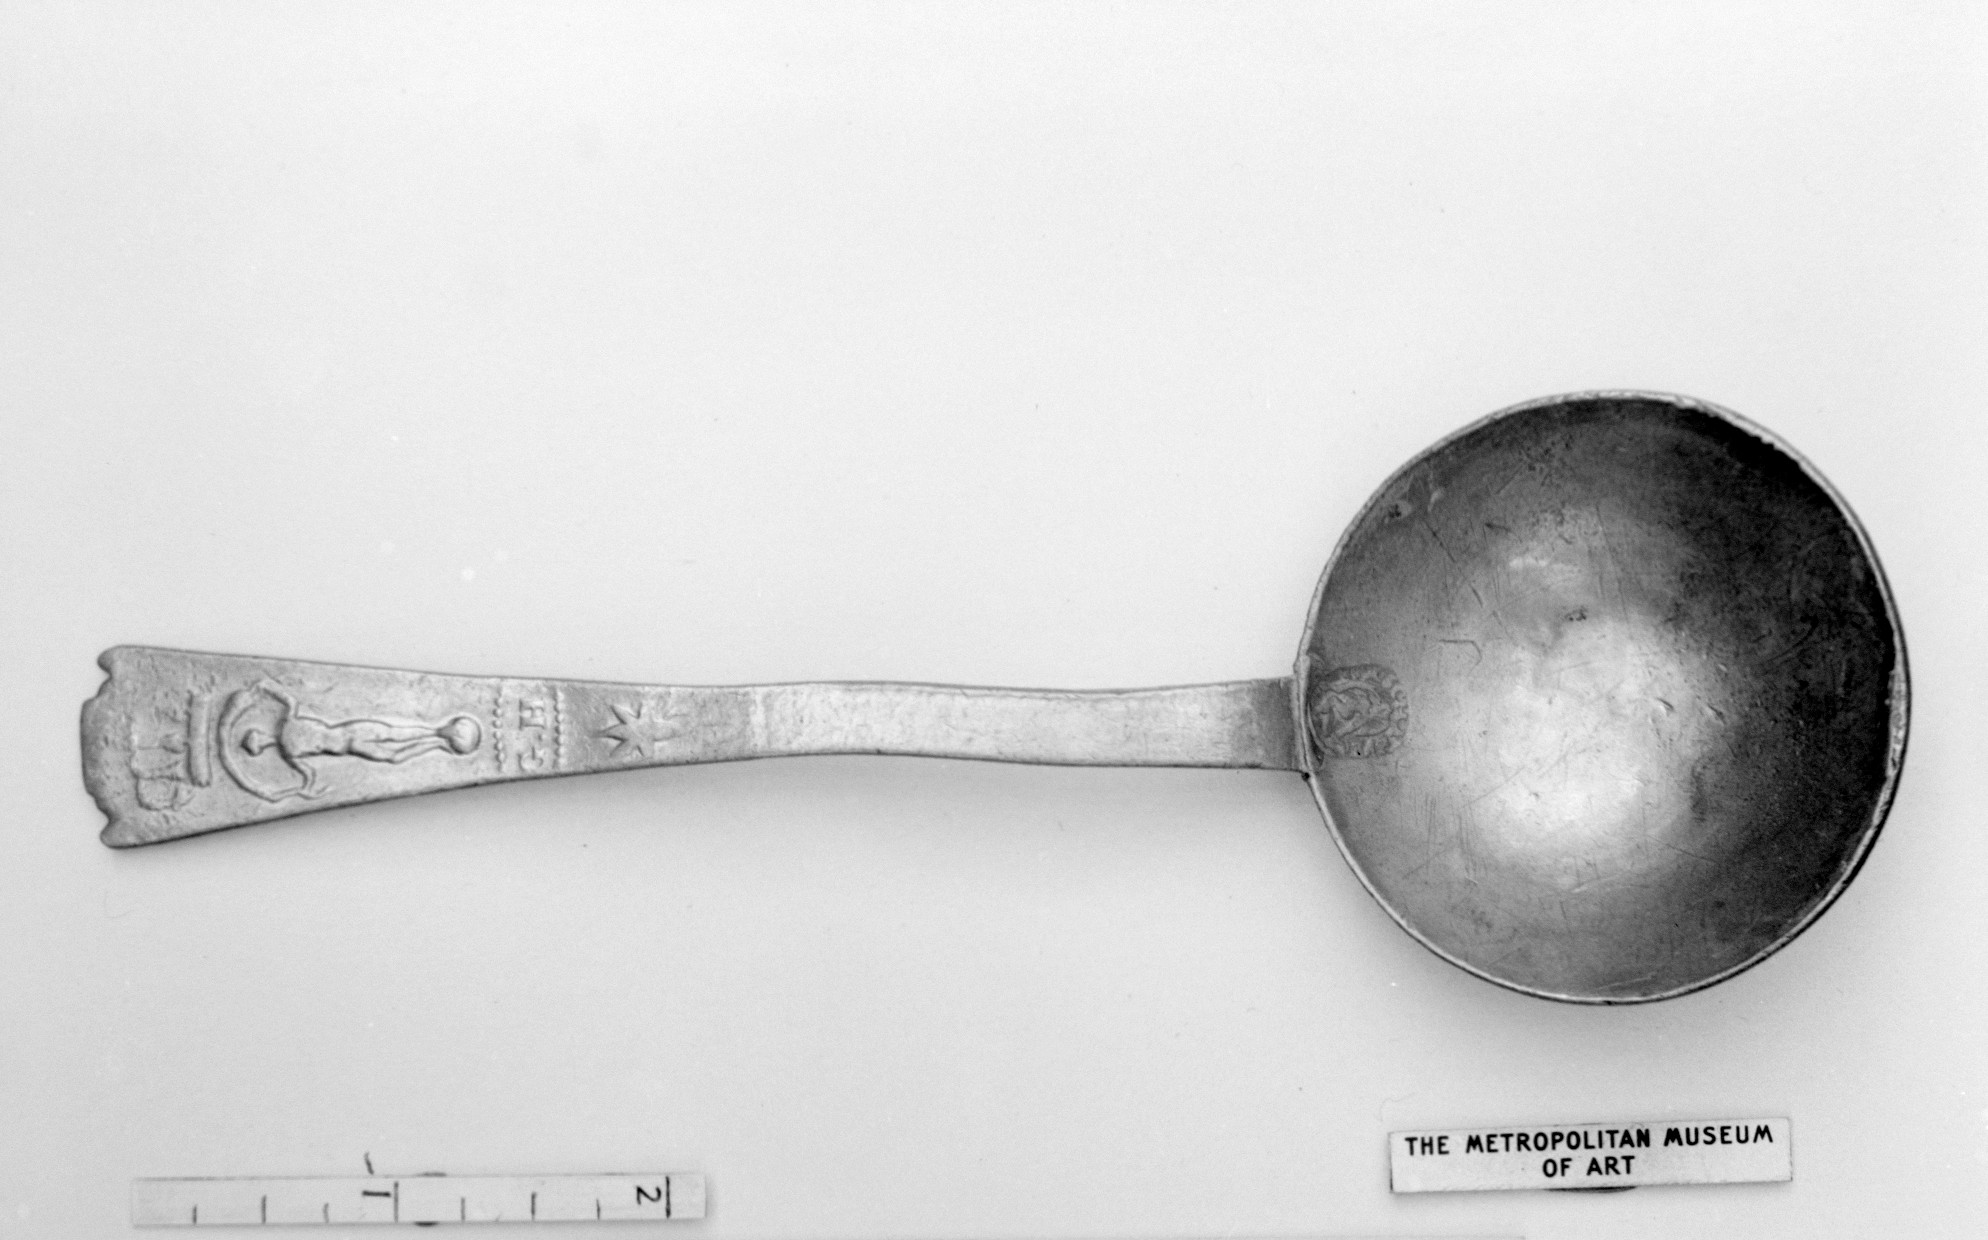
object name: spoon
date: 1701-1733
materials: pewter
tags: human figures